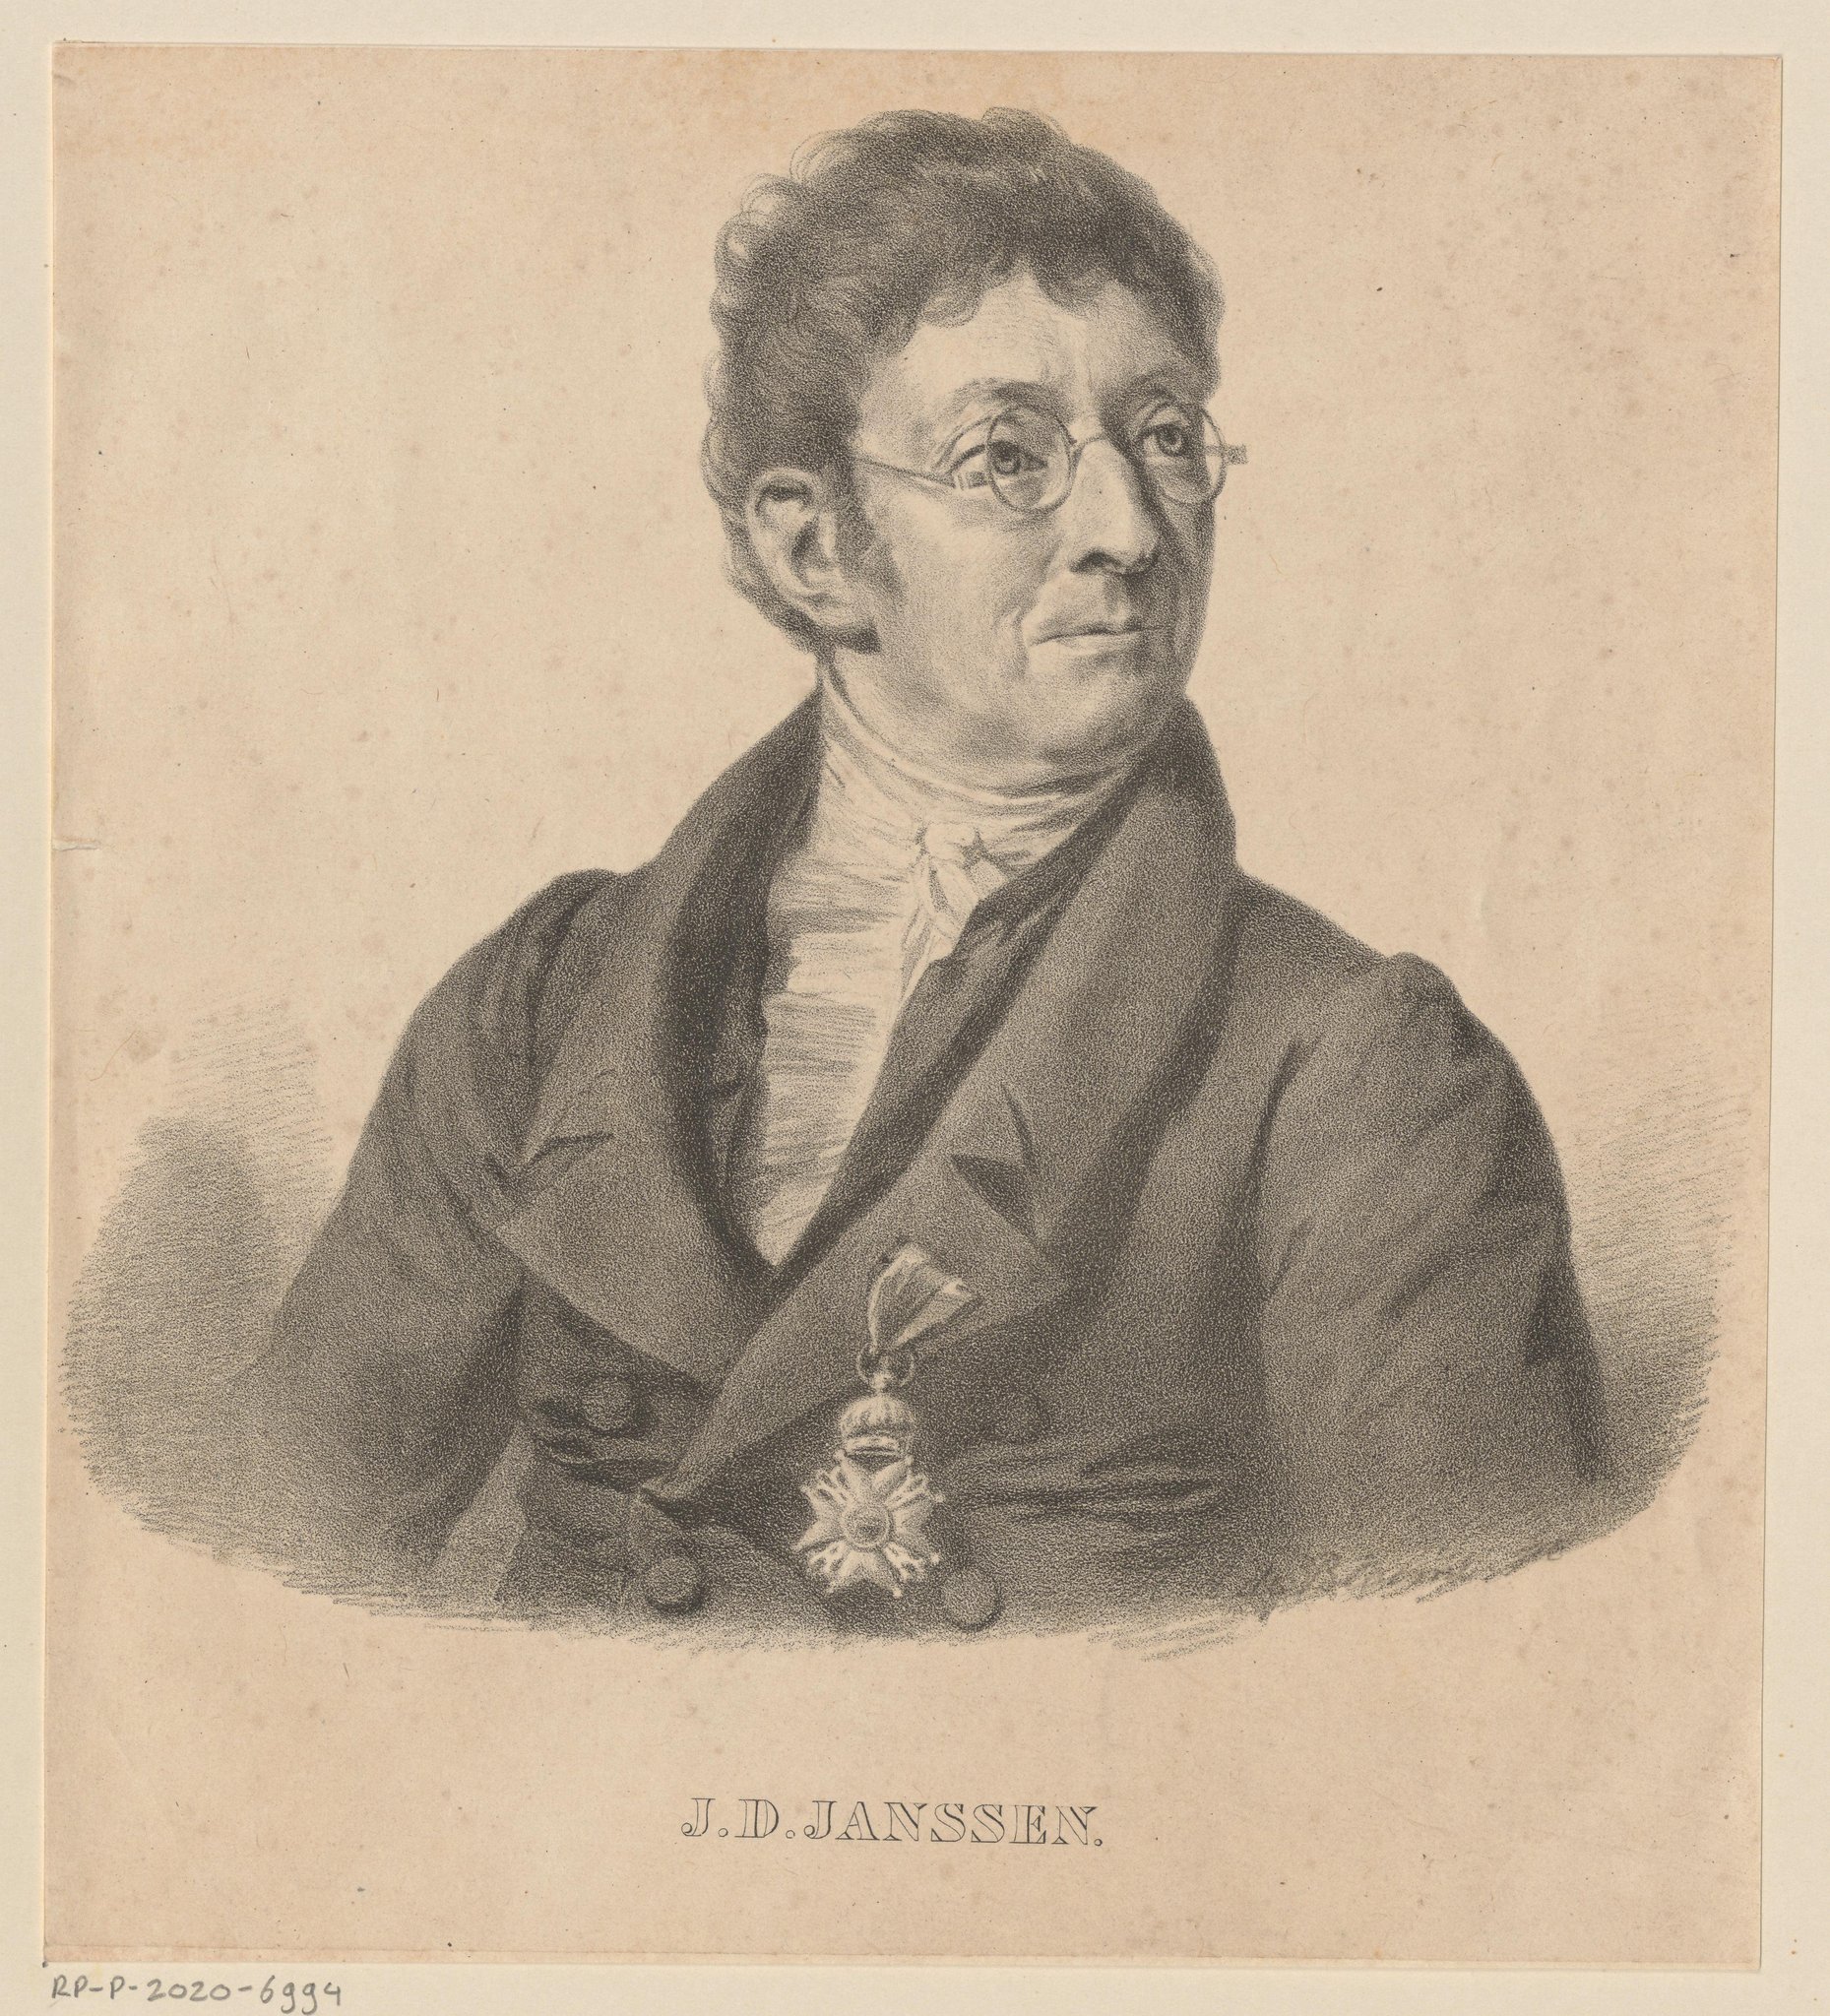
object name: print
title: Portret van Jacobus Didericus Janssen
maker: herman antonie de bloeme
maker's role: painter, print maker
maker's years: 1802-1867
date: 1812-1867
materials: paper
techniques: lithograph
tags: official; civil servant; functionary (in general), knighthood order, historical persons